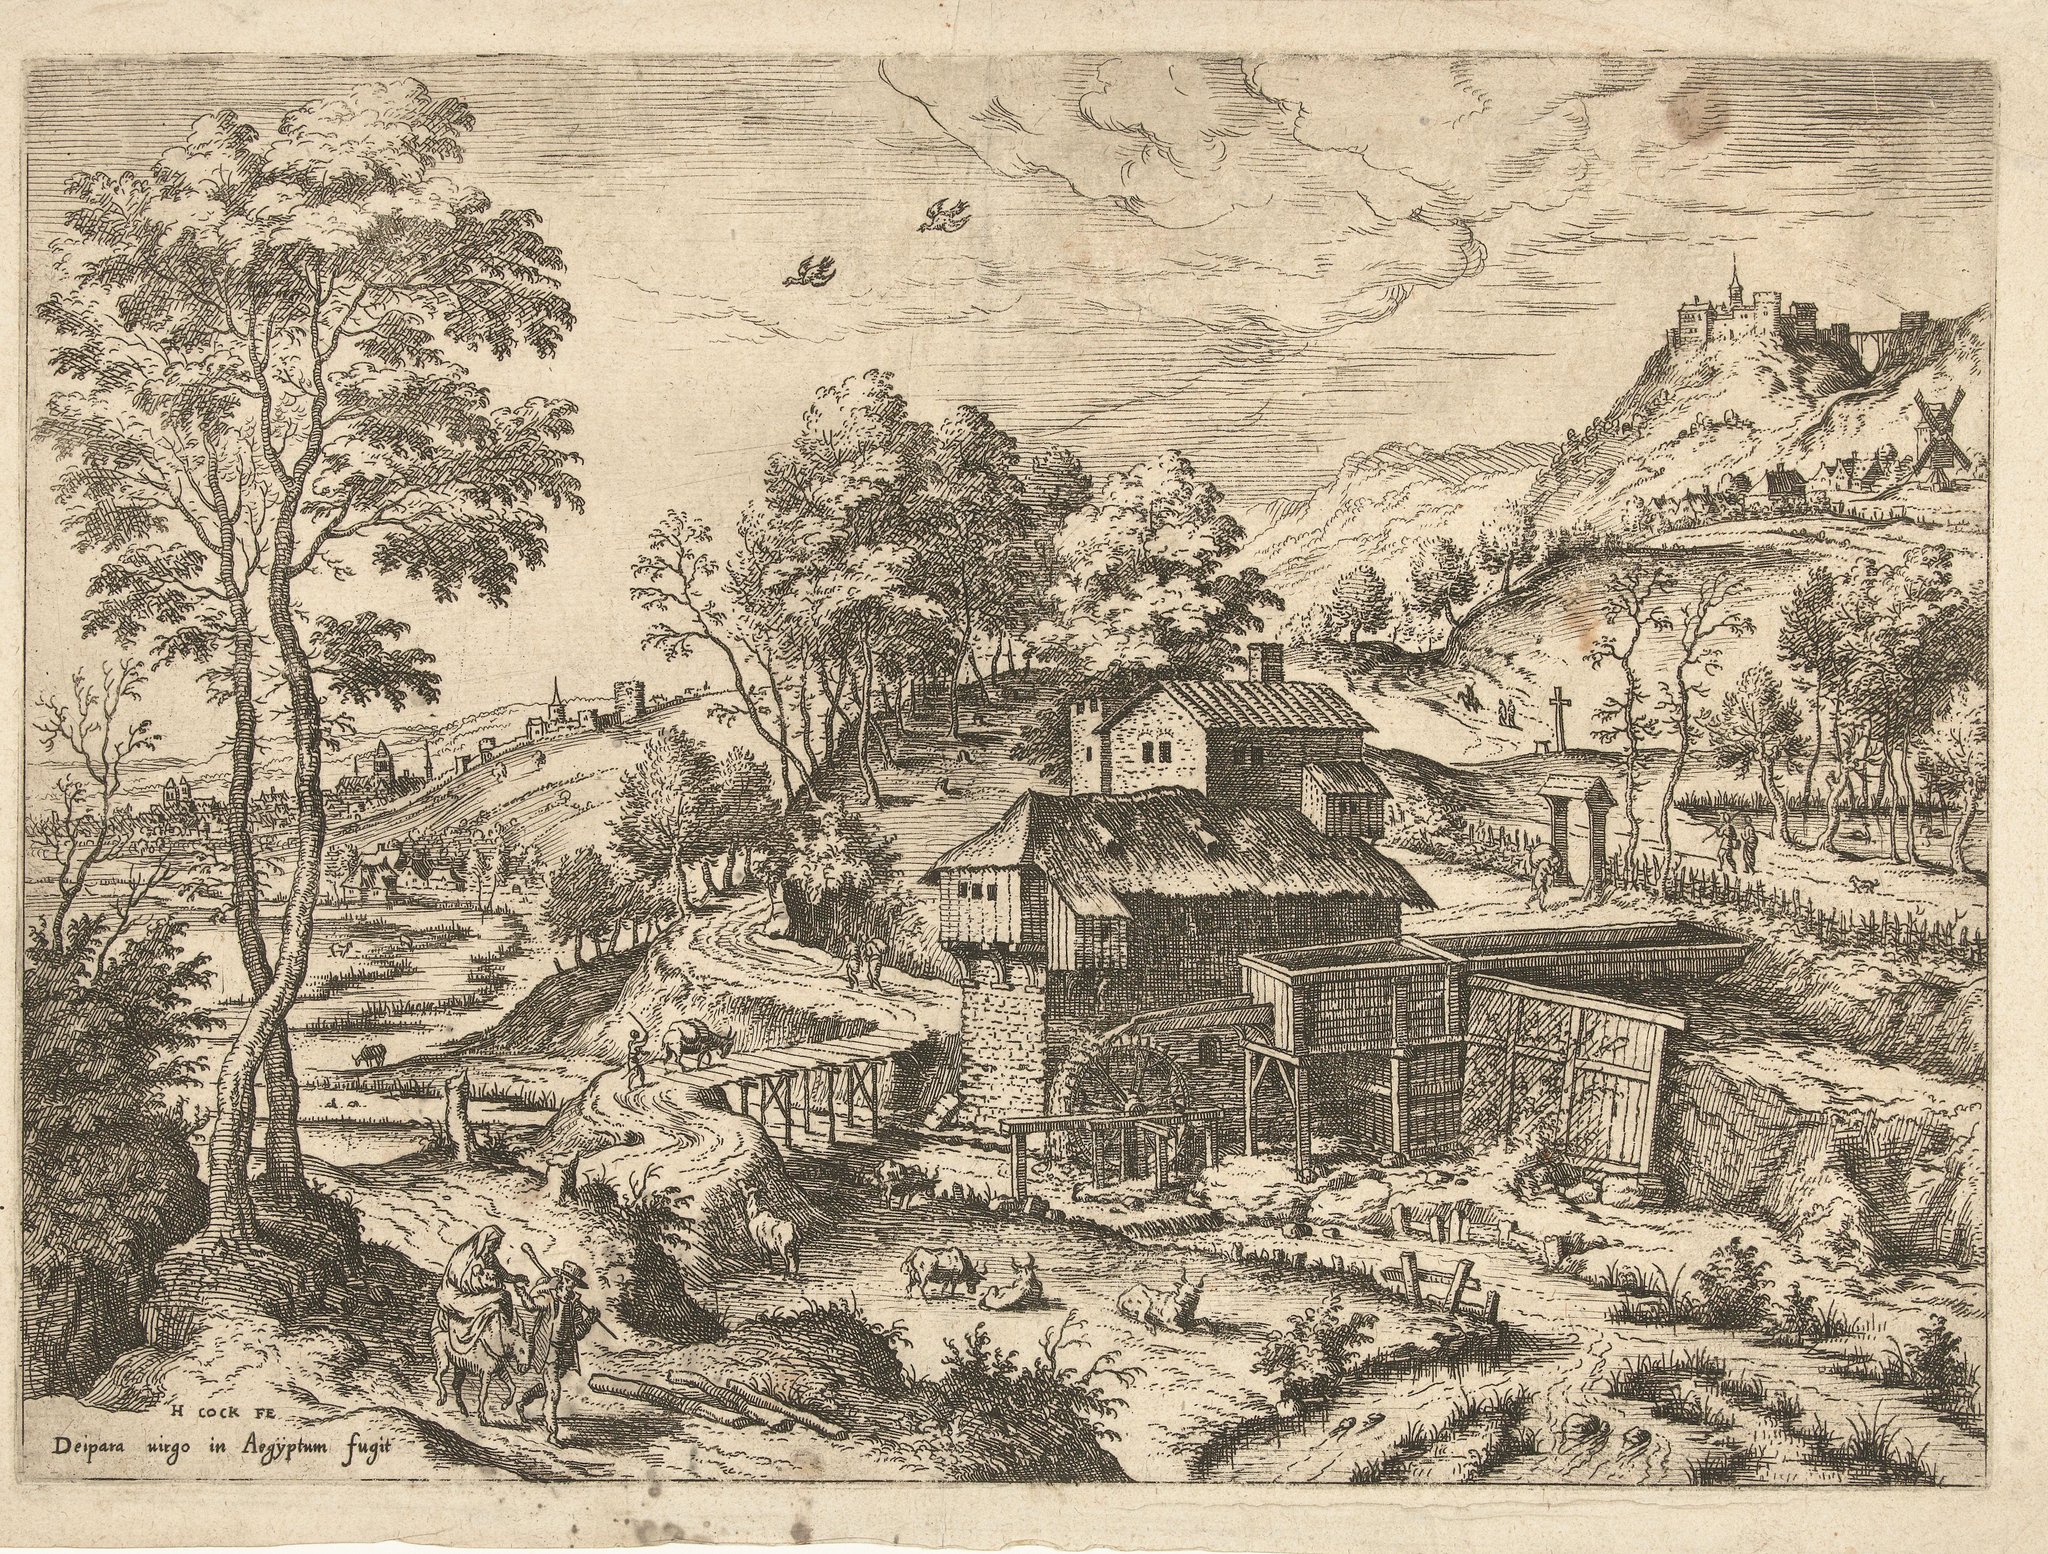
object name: print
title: Landschappen met bijbelse en mythologische scènes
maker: hieronymus cock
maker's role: print maker, publisher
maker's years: 1518-1570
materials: paper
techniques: etching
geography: antwerp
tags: the flight into egypt: mary, joseph, the child (and sometimes others) on their way; mary usually riding on an ass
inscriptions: collector's mark: Lugt 2228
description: Landschap met een watermolen bij een rivier. Links op het pad Maria en Jozef op de vlucht naar Egypte. Maria houdt Christus in haar arm en rijdt op een ezel. Jozef draagt een hoed en een stok en houdt Marias hand vast. Prent uit een serie van 13 landschappen met bijbelse en mythologische scènes.